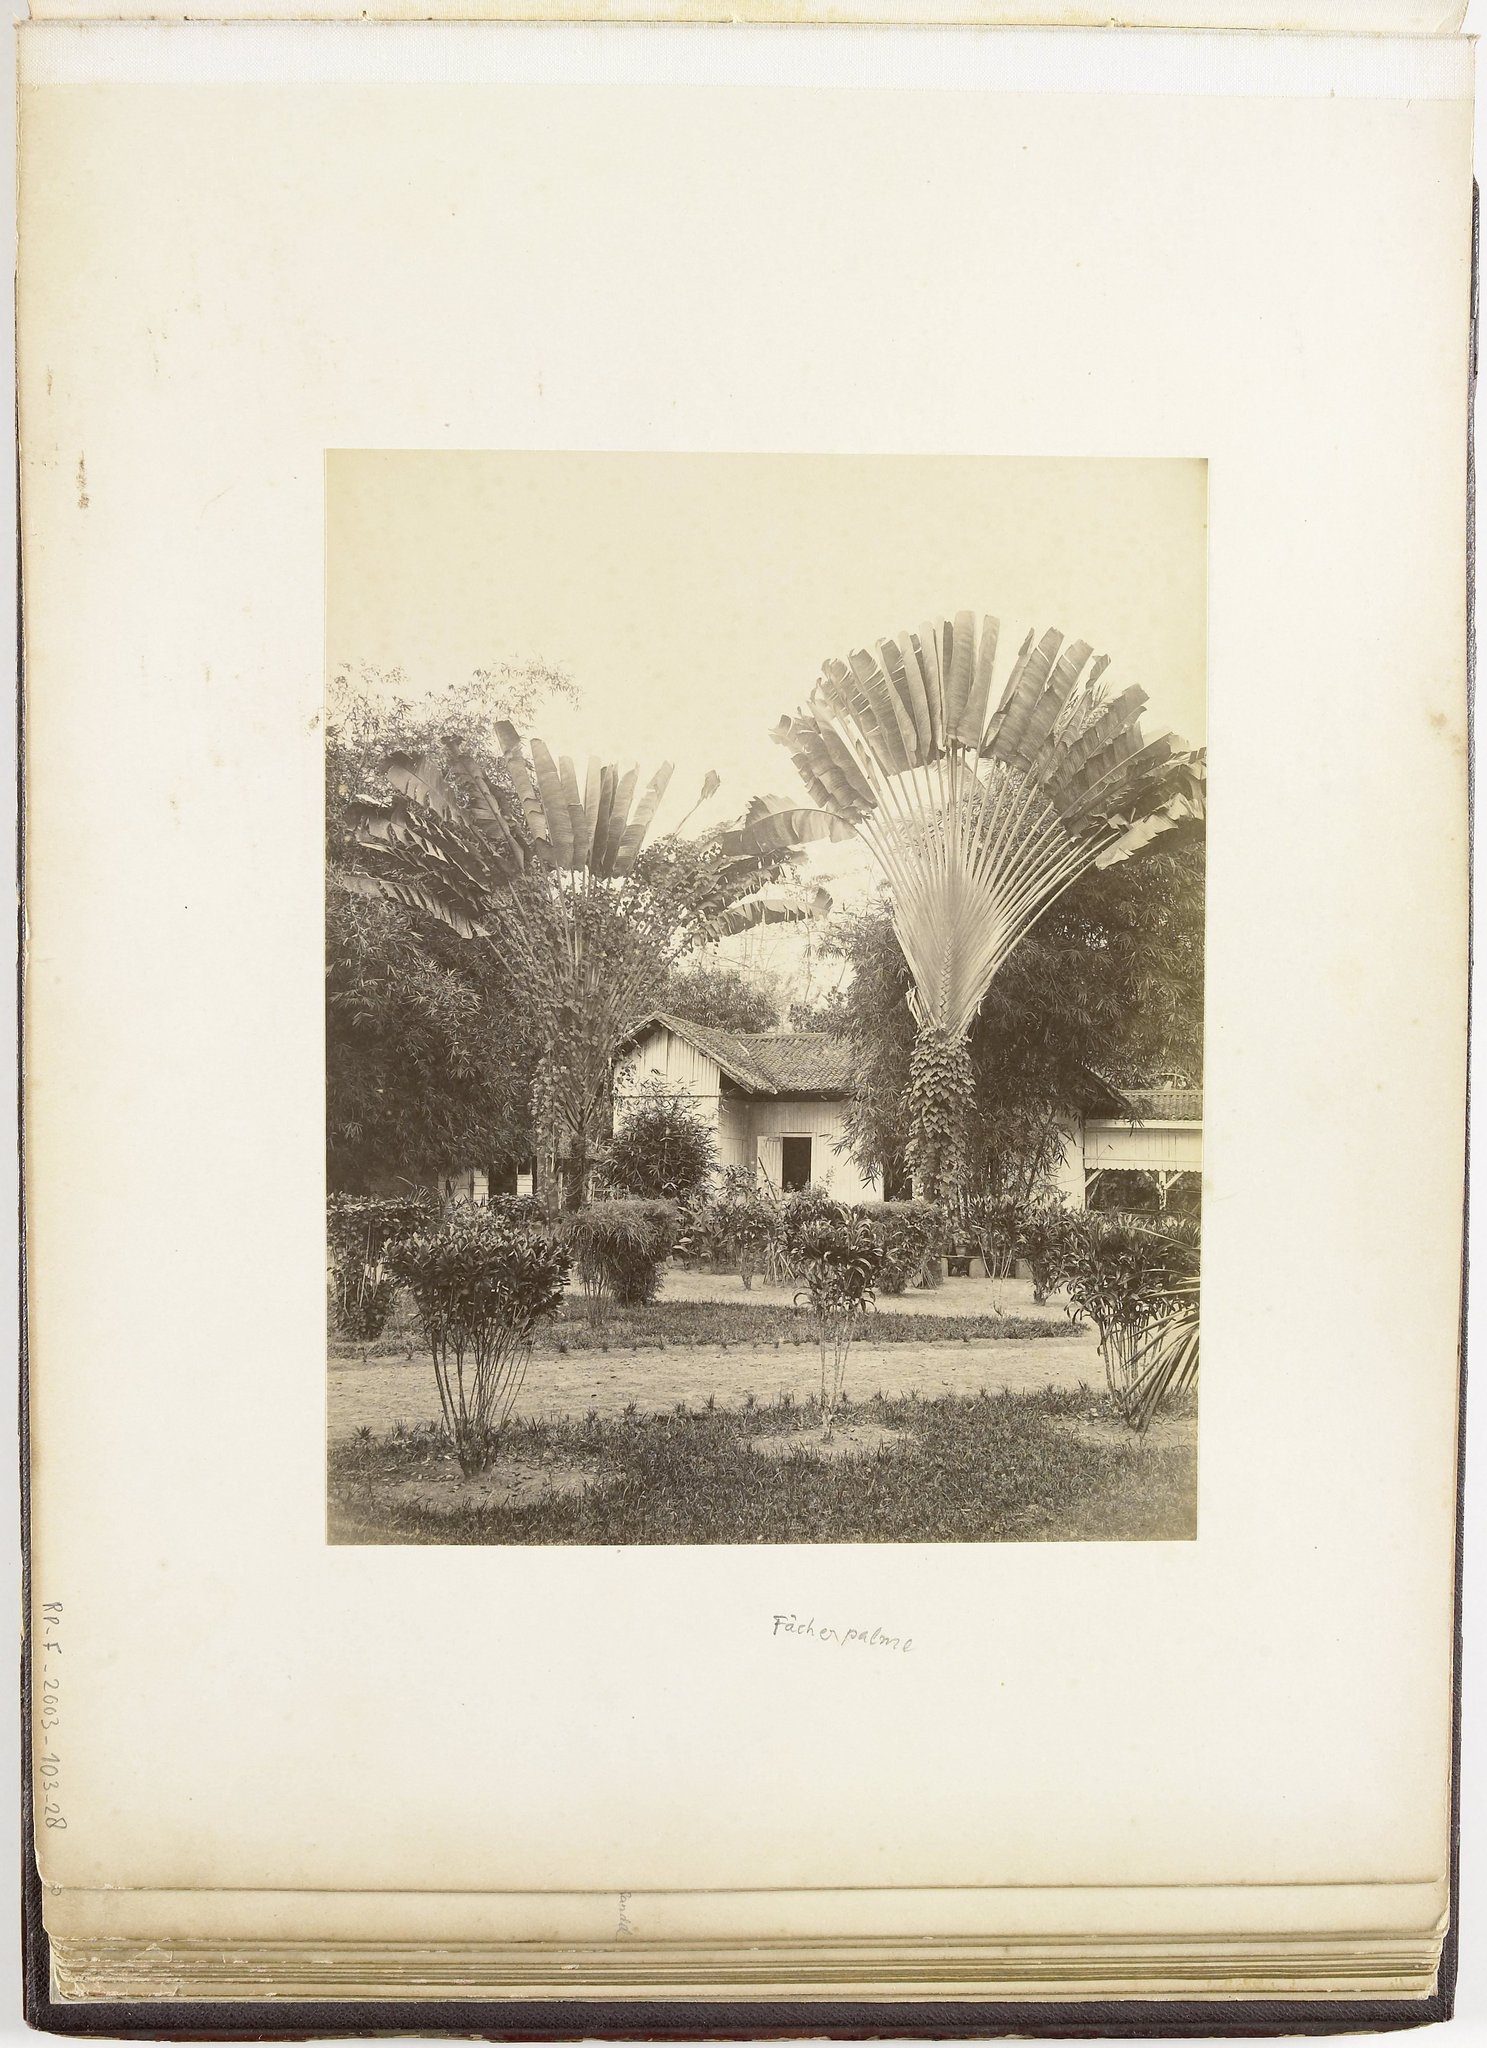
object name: photograph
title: Gezicht op huis met tuin en palmbomen, Langkat Sumatra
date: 1890-1900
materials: cardboard, paper, photographic support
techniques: albumen print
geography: bindjai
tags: sumatra